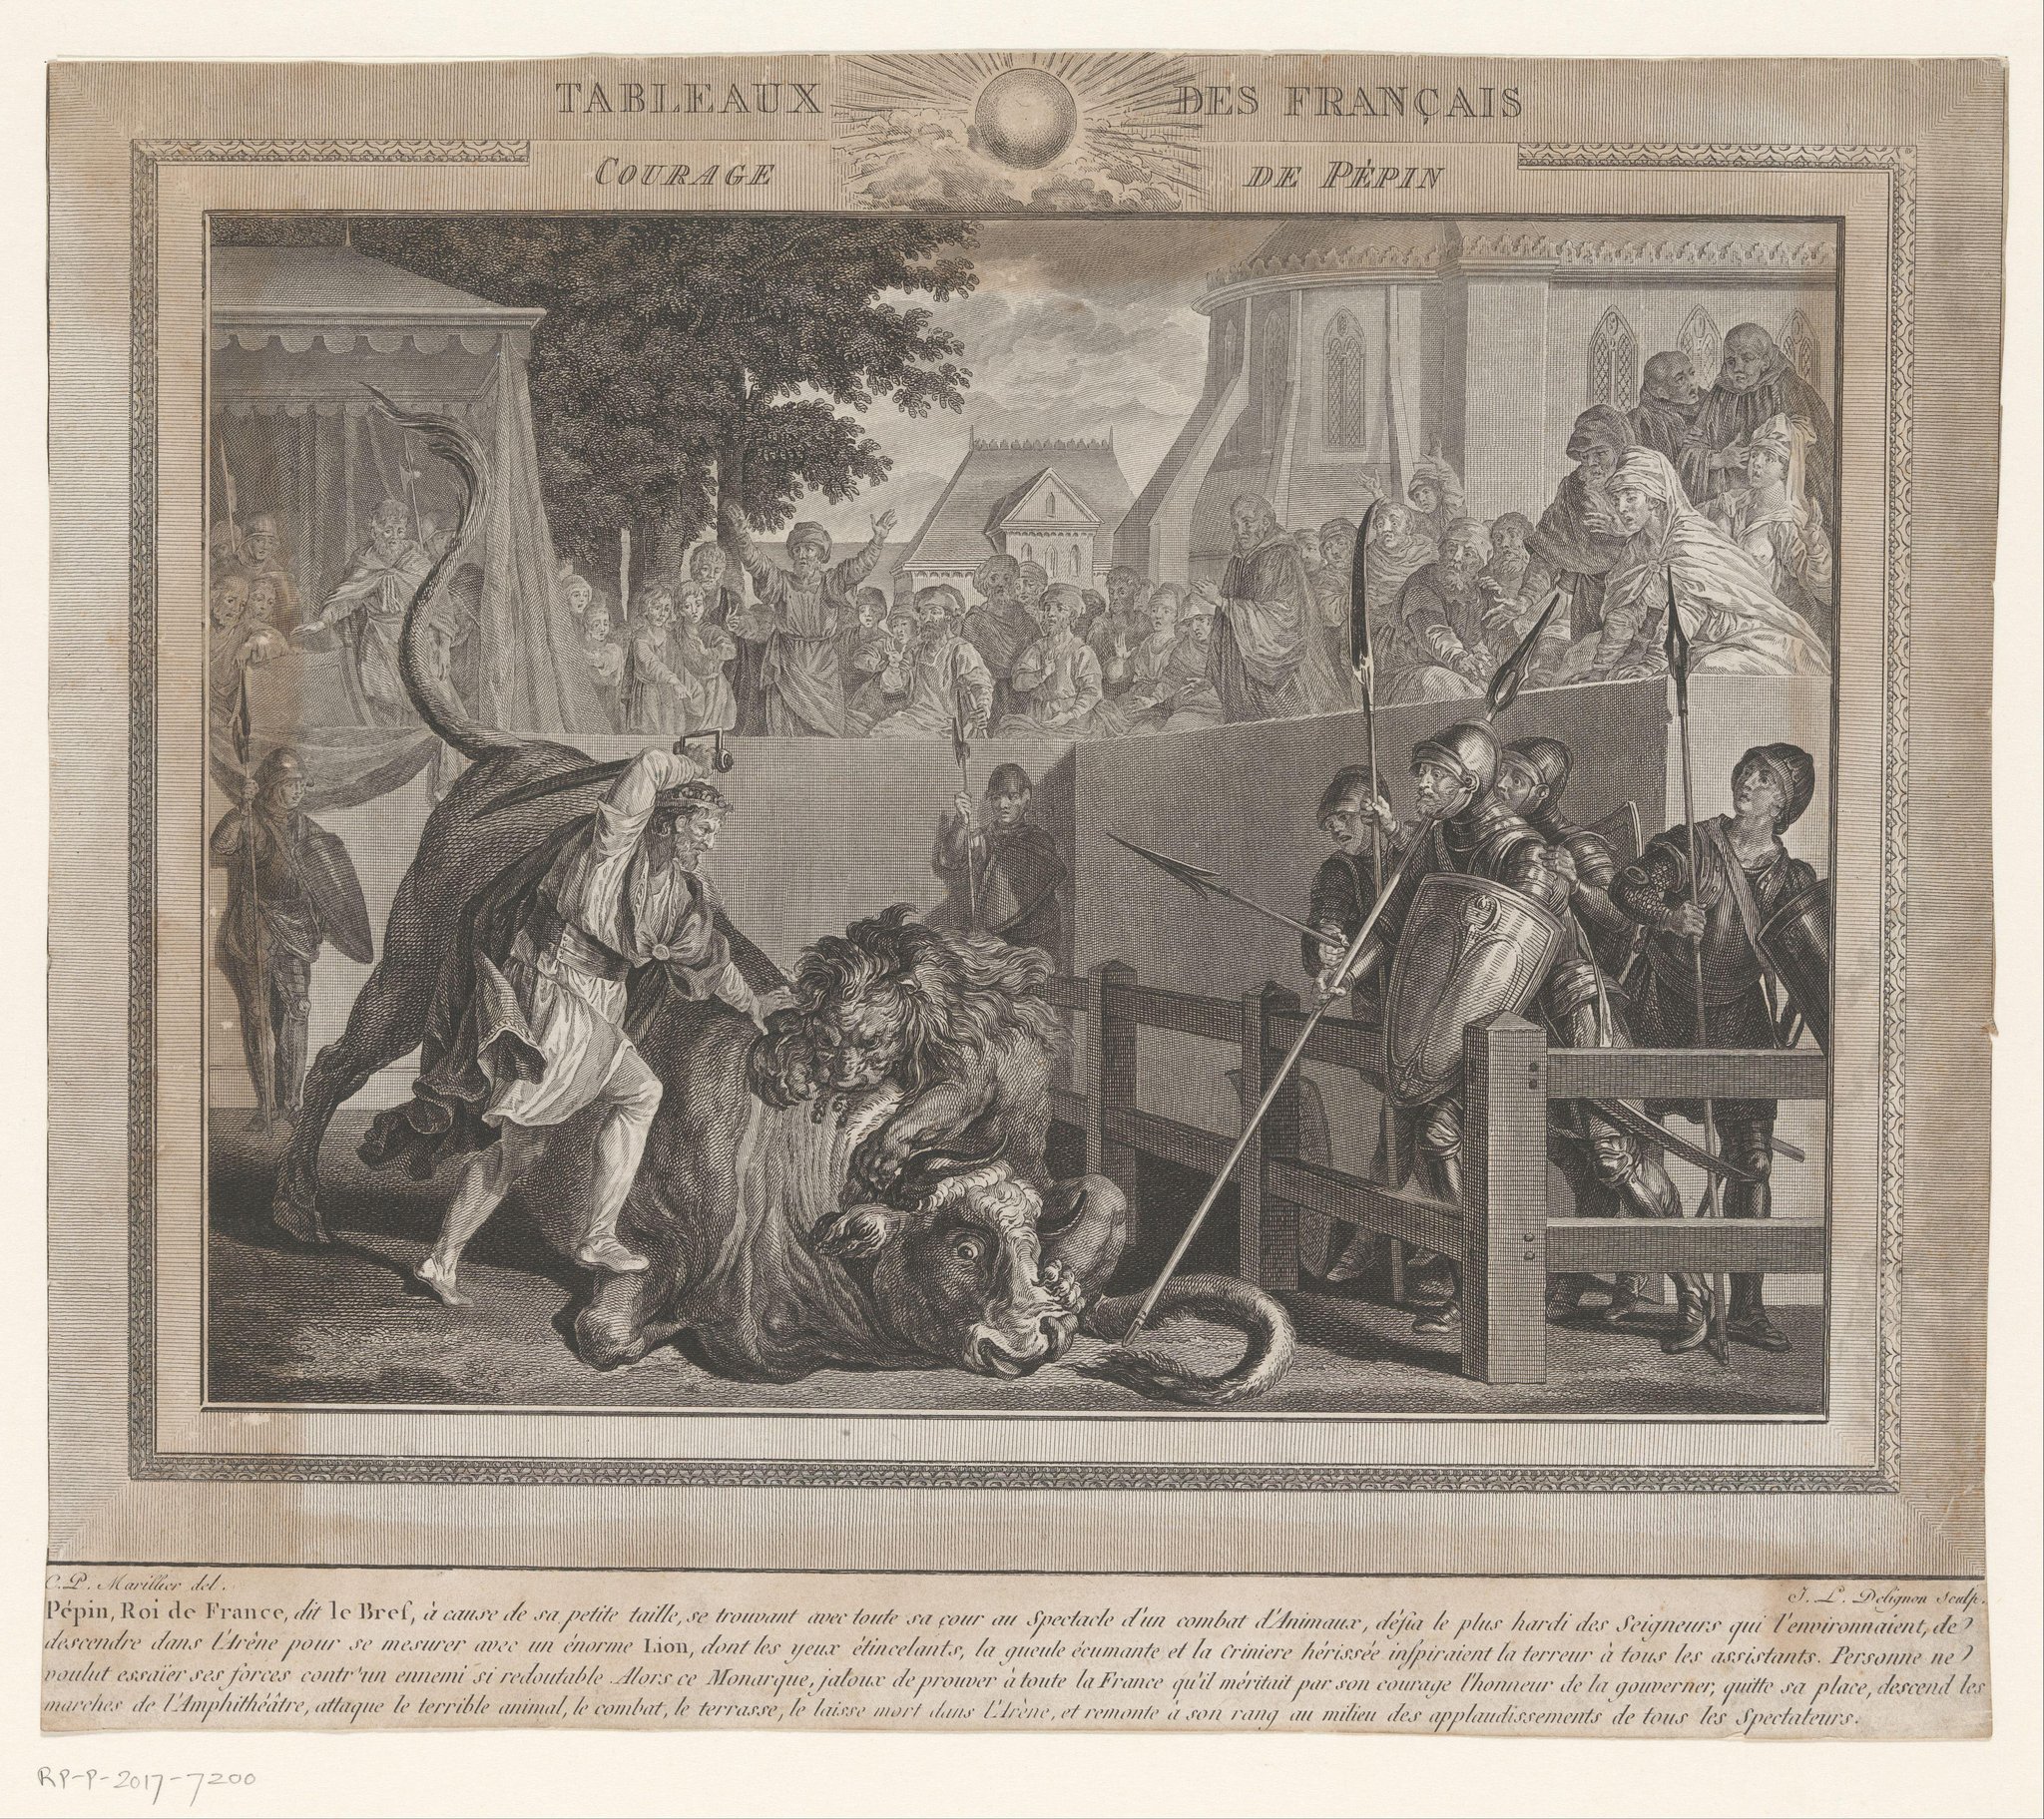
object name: print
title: Dapperheid van koning Pepijn de Korte, ca. 751-768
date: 1765-1804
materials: paper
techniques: etching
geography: france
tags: liège, tormenting mammals ~ sport and recreation, bull, beasts of prey, predatory animals: lion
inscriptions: collector's mark: Lugt 2228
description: Dapperheid van Pepijn de Korte, eerste koning der Franken, ca. 751-768. Pepijn springt in de arena tijdens een gevecht tussen een leeuw en een stier. In een omlijsting met centraal een stralende zon. Met vierregelig onderschrift in het Frans. Mogelijk onderdeel van een serie 'Tableaux des Français'.